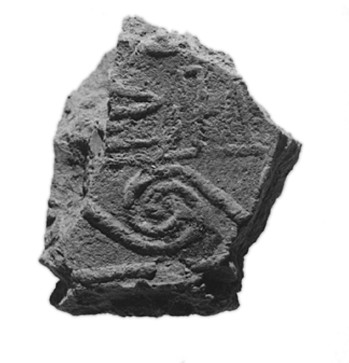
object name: sealing fragment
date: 2030-1640 BCE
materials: clay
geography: egypt